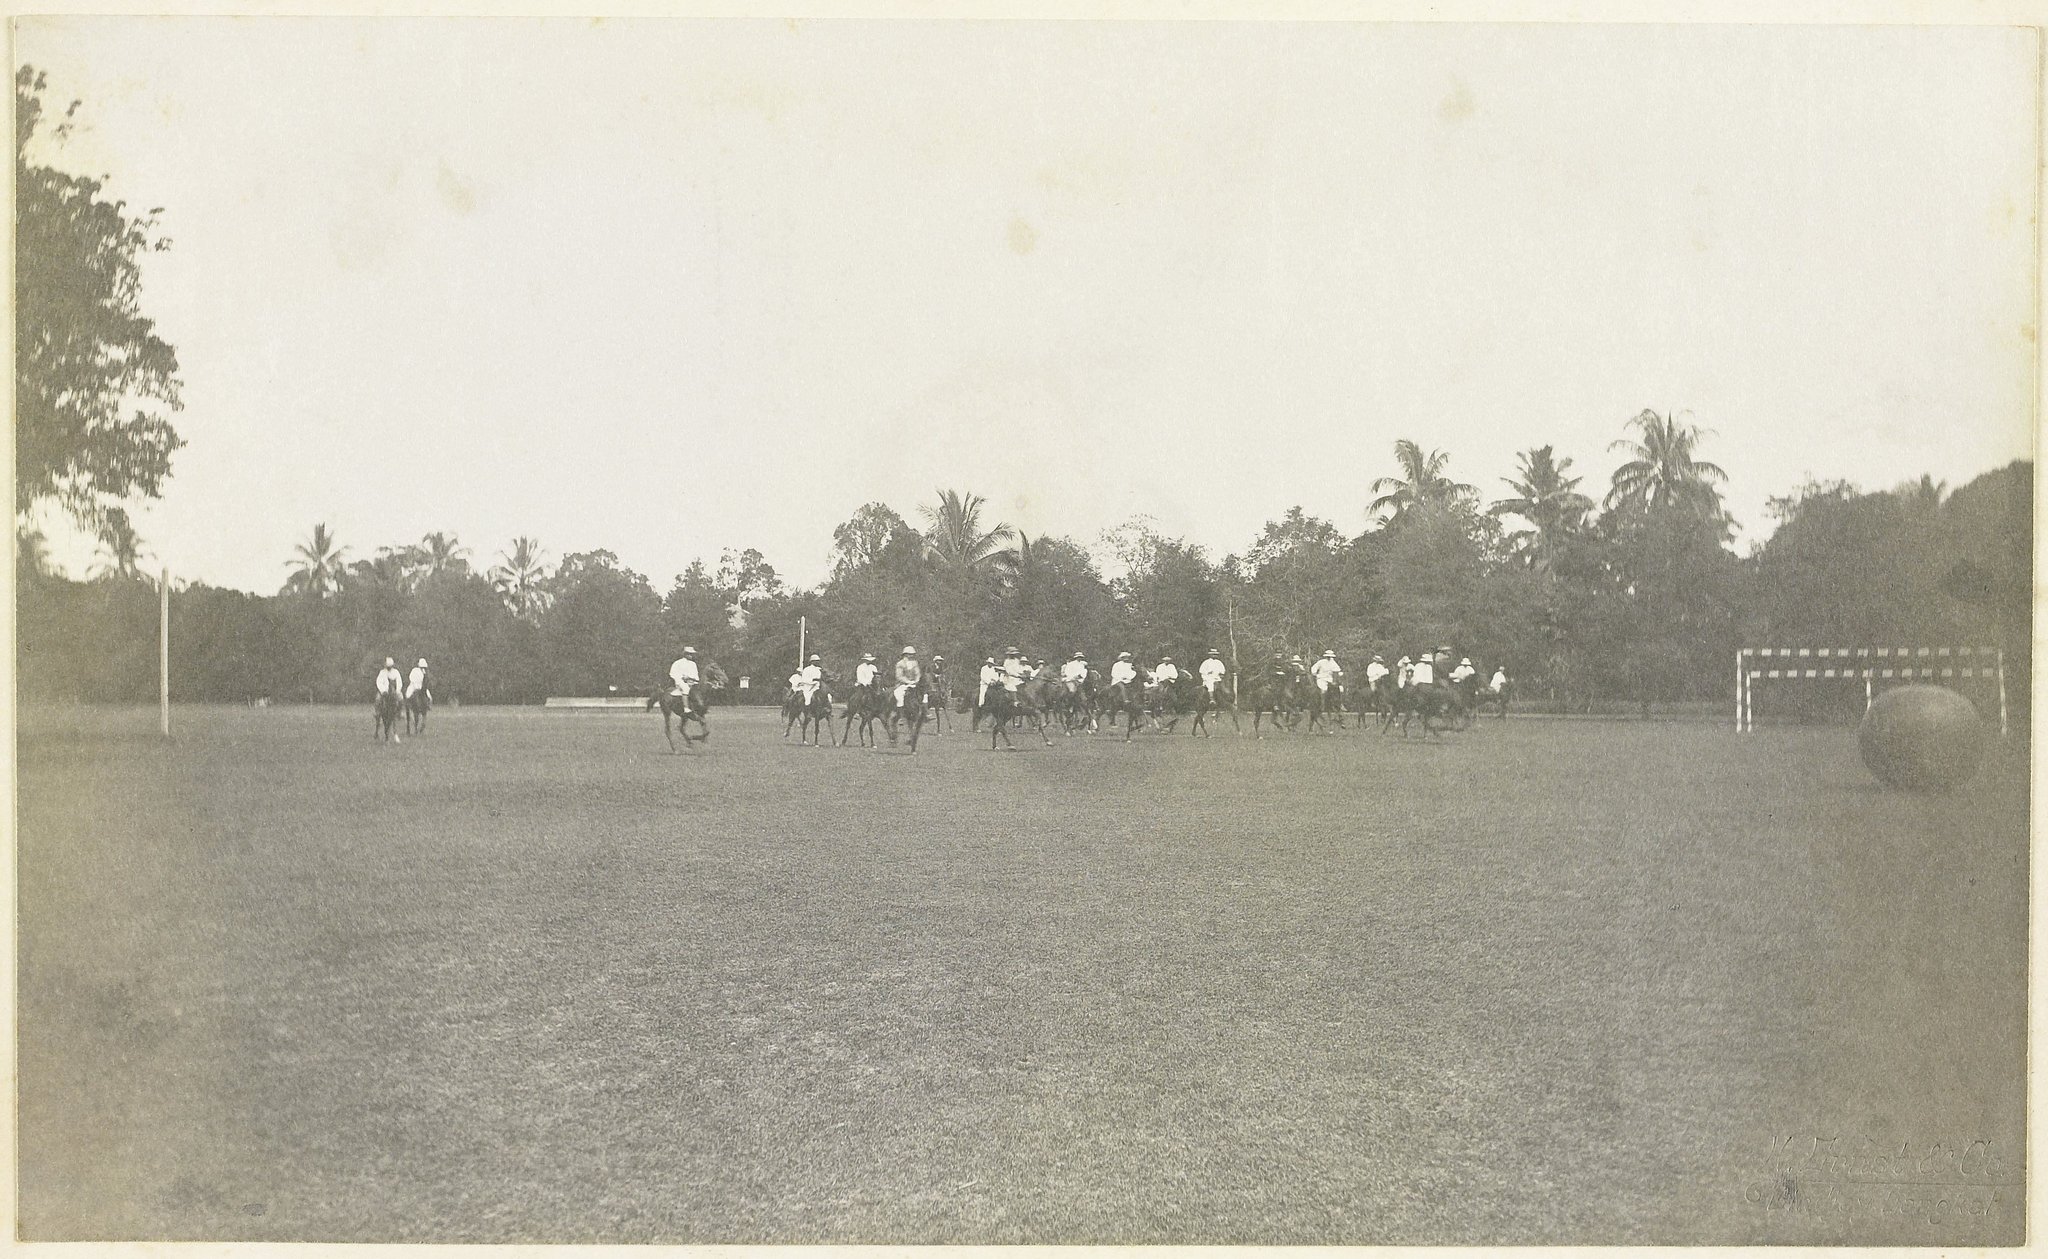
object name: photograph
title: Ruiterspel met grote bal, Medan Sumatra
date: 1900-1905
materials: cardboard, paper, photographic support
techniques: platinum process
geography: bindjai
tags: sumatra